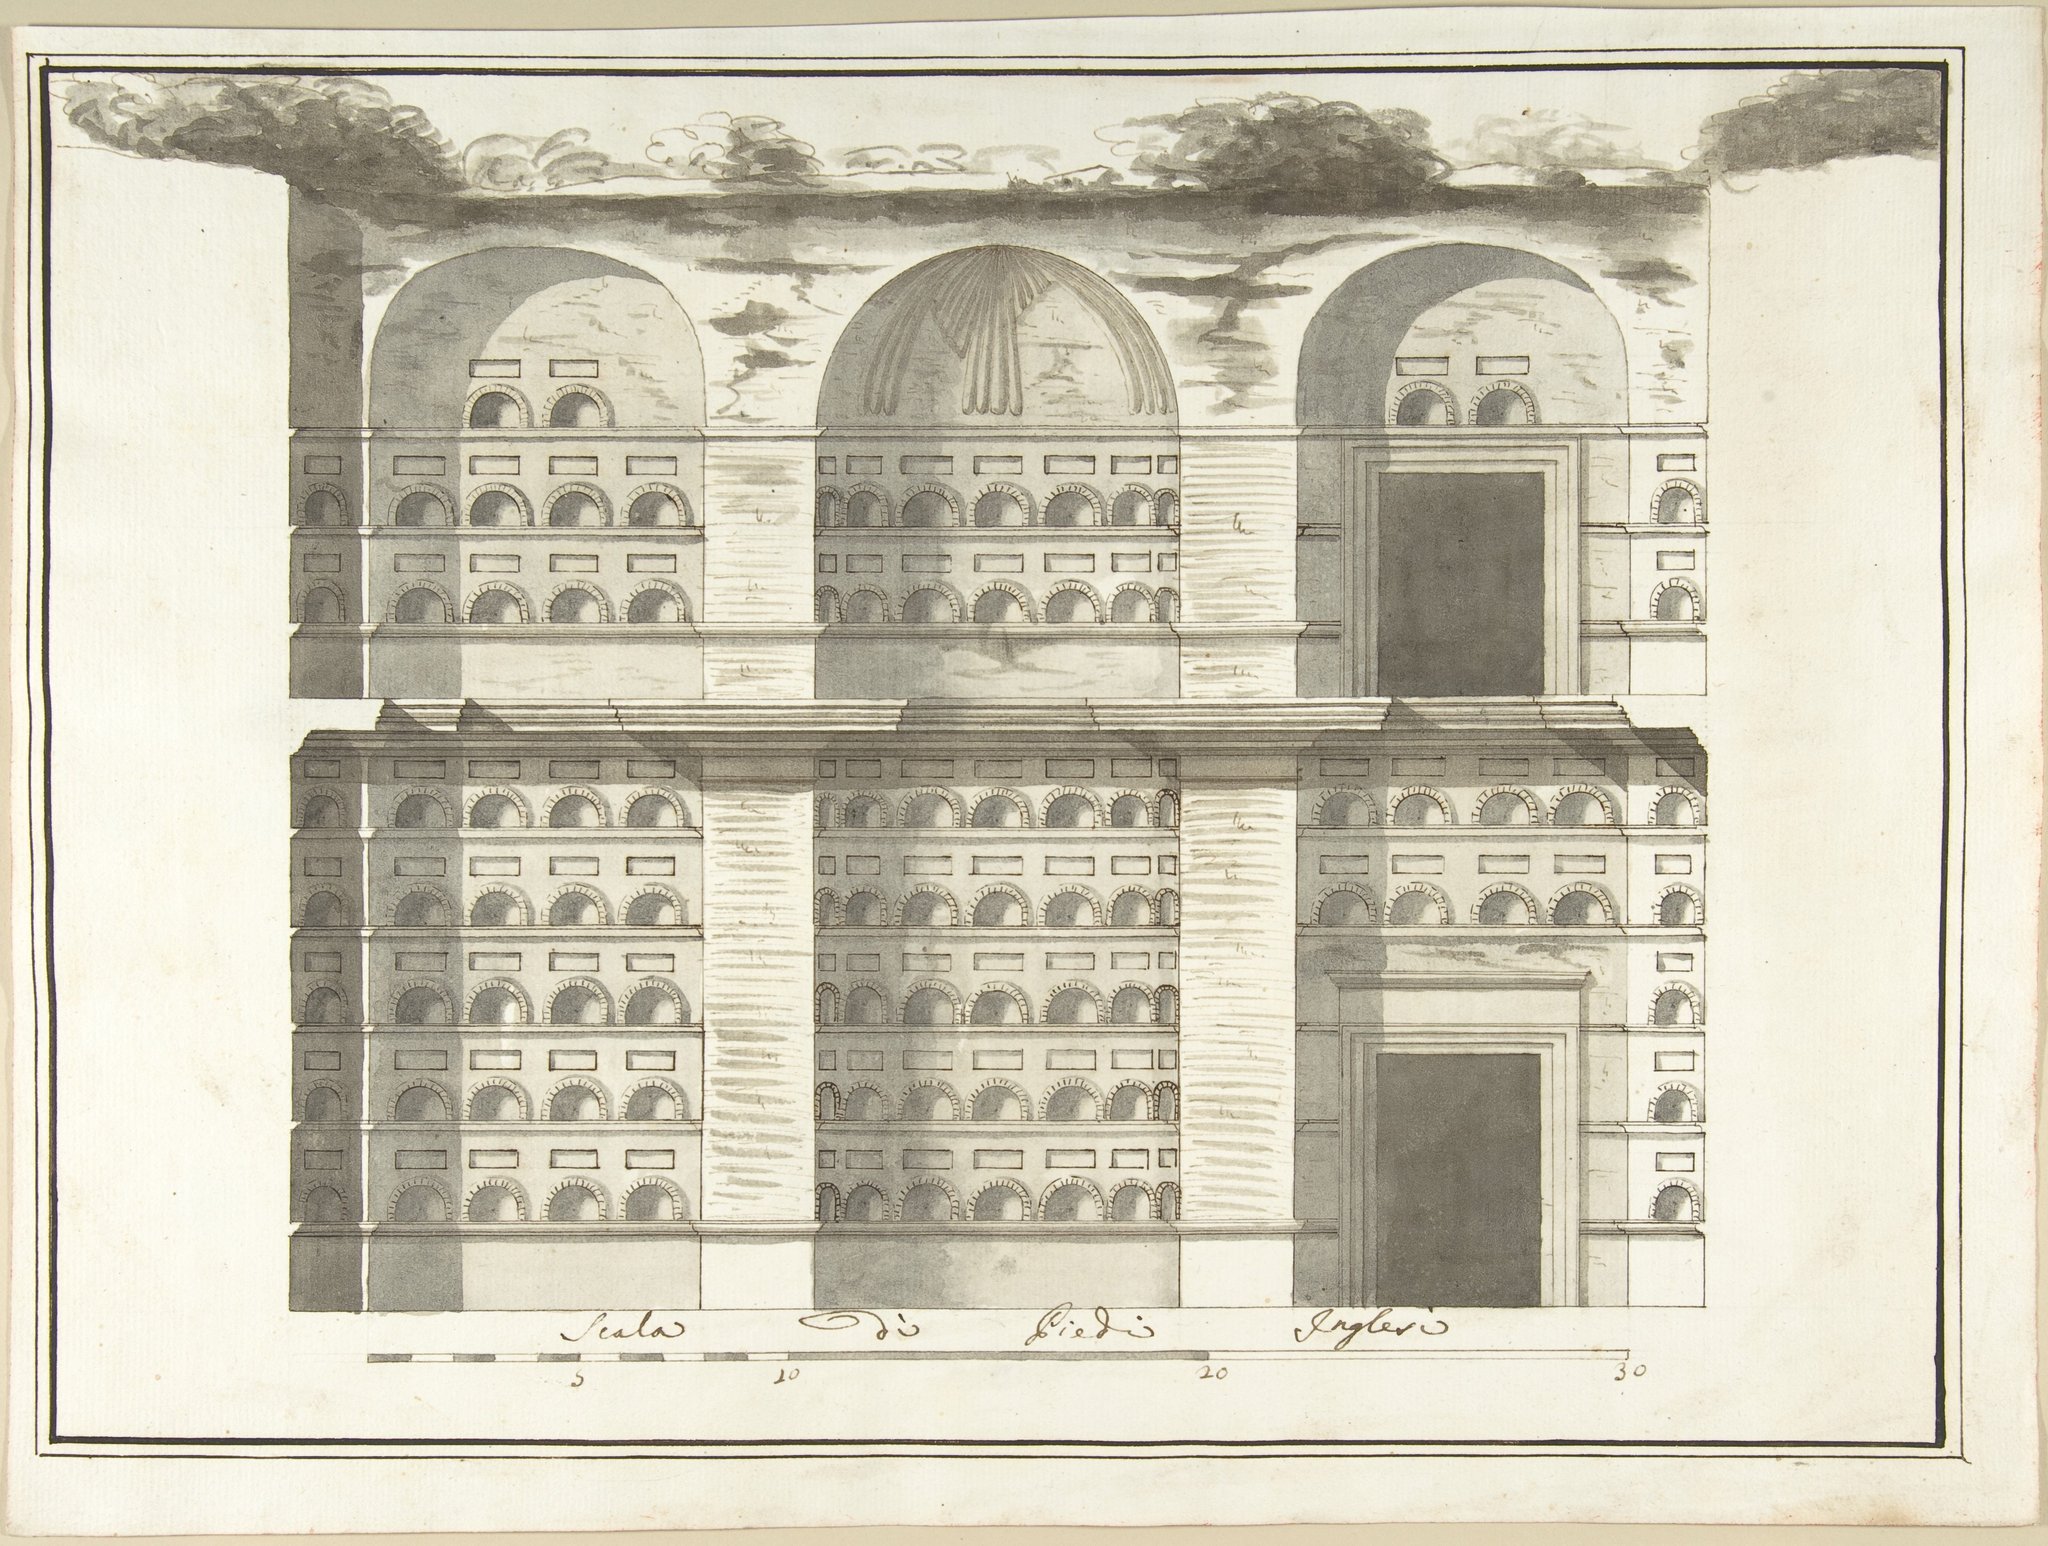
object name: drawing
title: Section (Interior Elevation) of a Columbarium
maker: pietro paolo coccetti (cocchetti)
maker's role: artist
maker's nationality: italian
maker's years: 1710-1727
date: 1710-1727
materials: graphite, ink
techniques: brush, pen, wash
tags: architecture